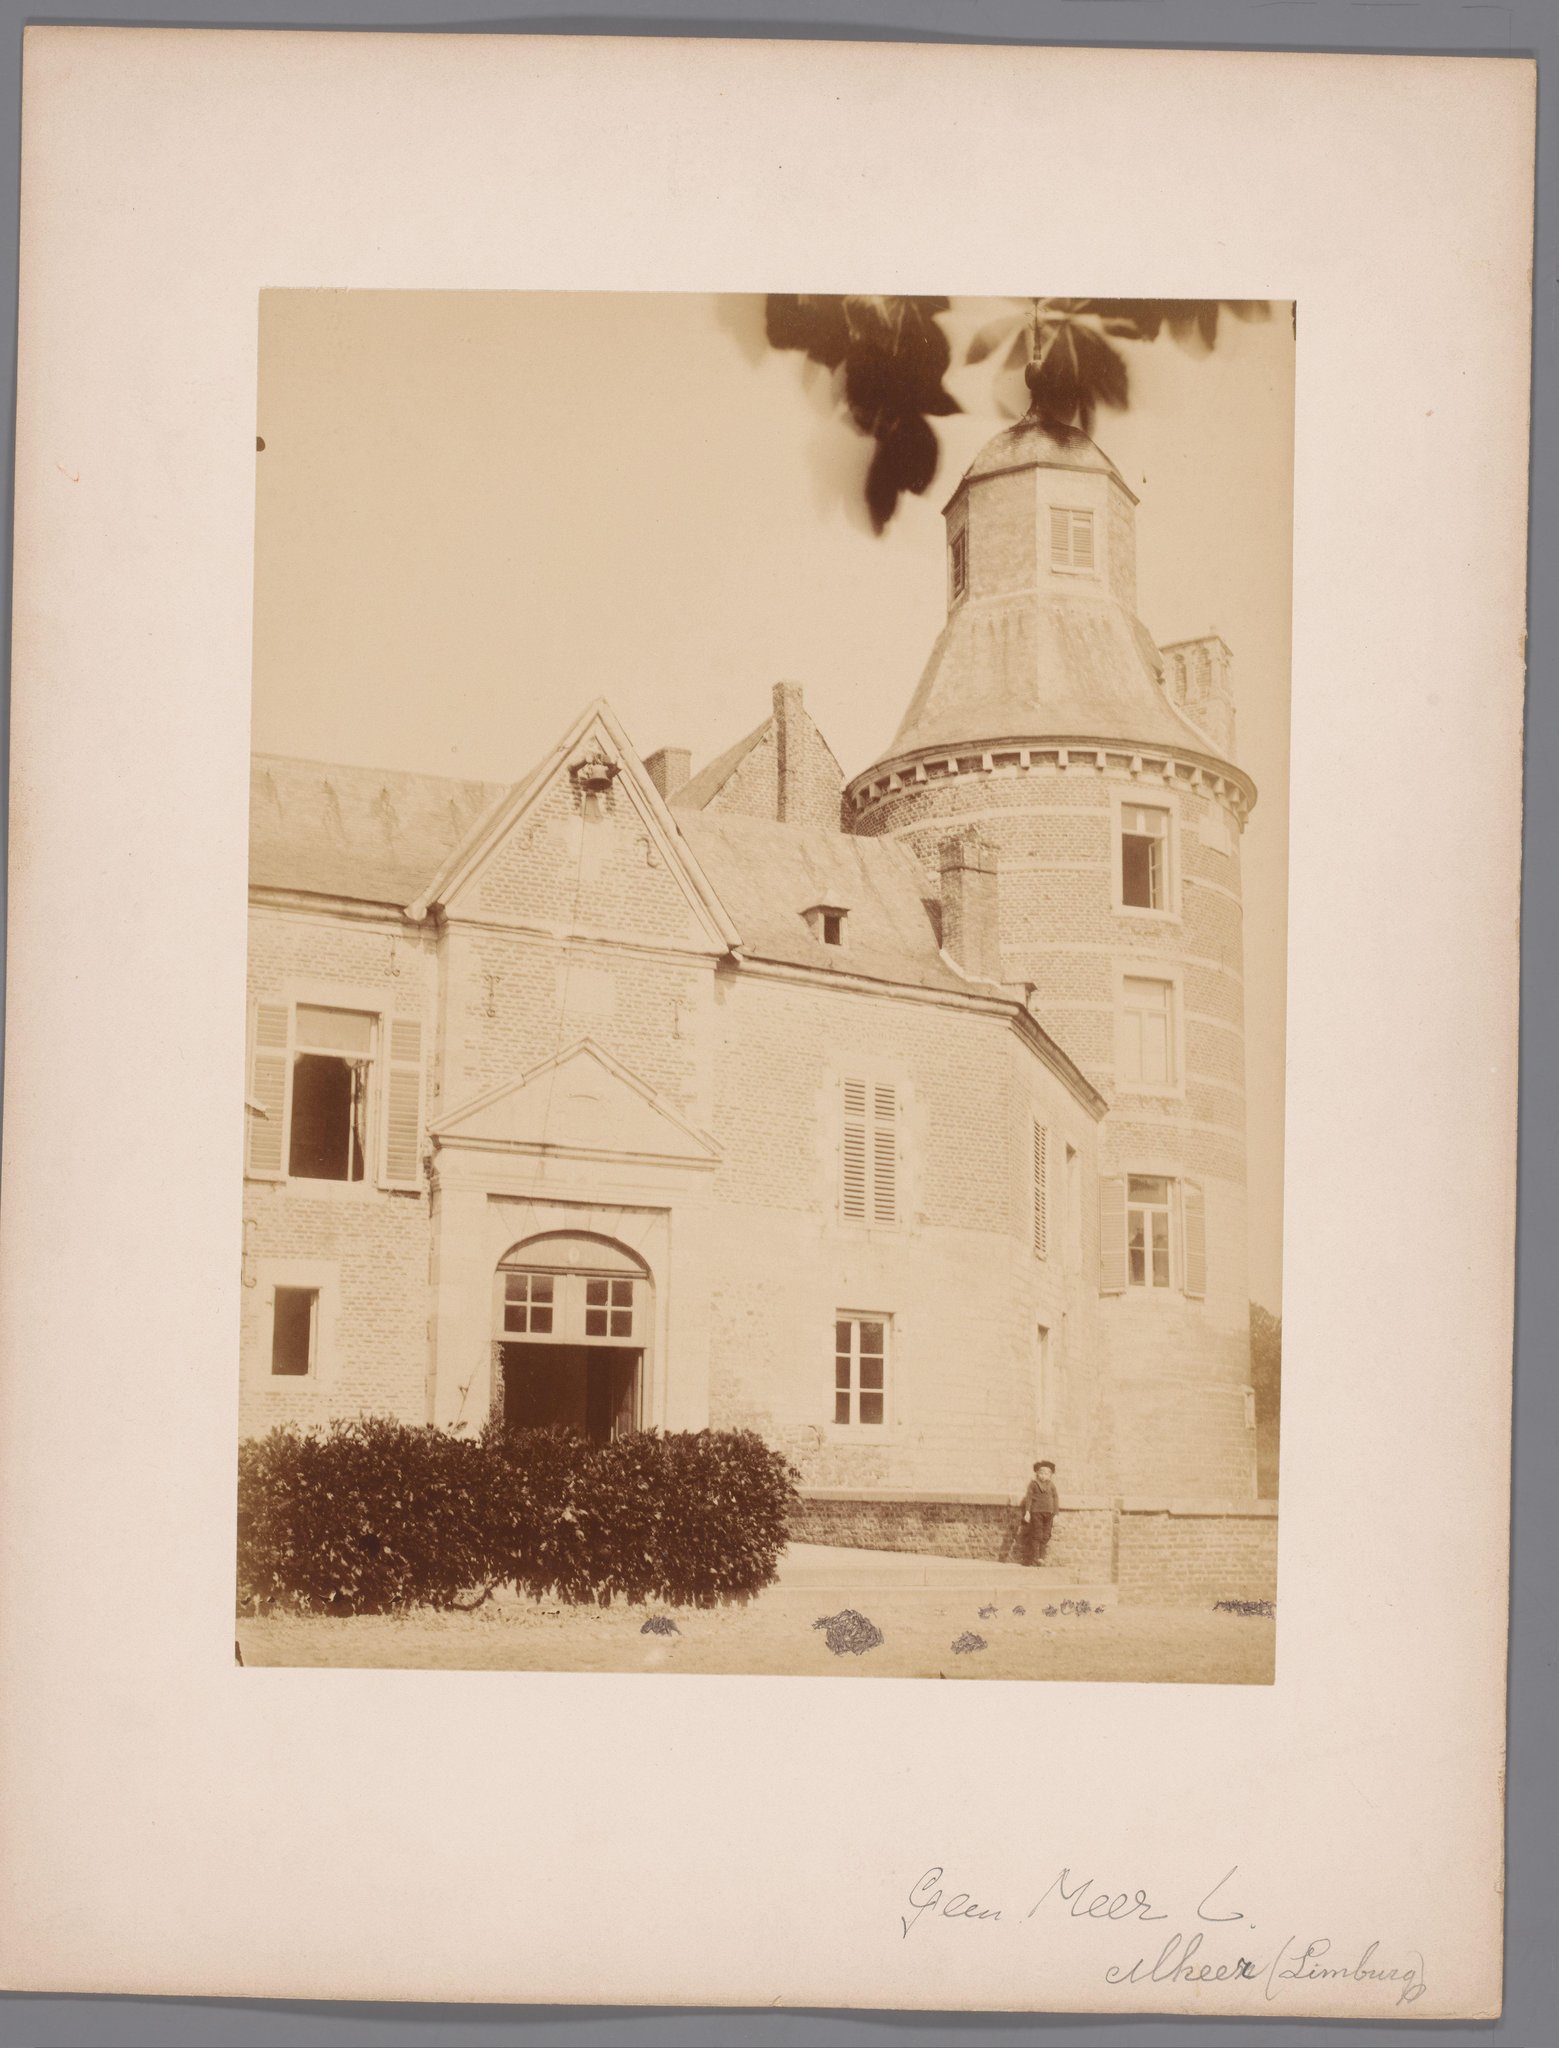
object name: photograph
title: Hoofdhuis met toren van het Kasteel van Mheer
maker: anoniem (monumentenzorg)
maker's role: fotograaf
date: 1890-1920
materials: cardboard, photographic support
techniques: albumen print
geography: limburg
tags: castle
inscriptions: annotation: ‘Mheer (Limburg)/ Kasteel en boerderij/ (hoofd ingang kasteel)’, annotation: ‘Gem. Meer. L/ Mheer (Limburg)’